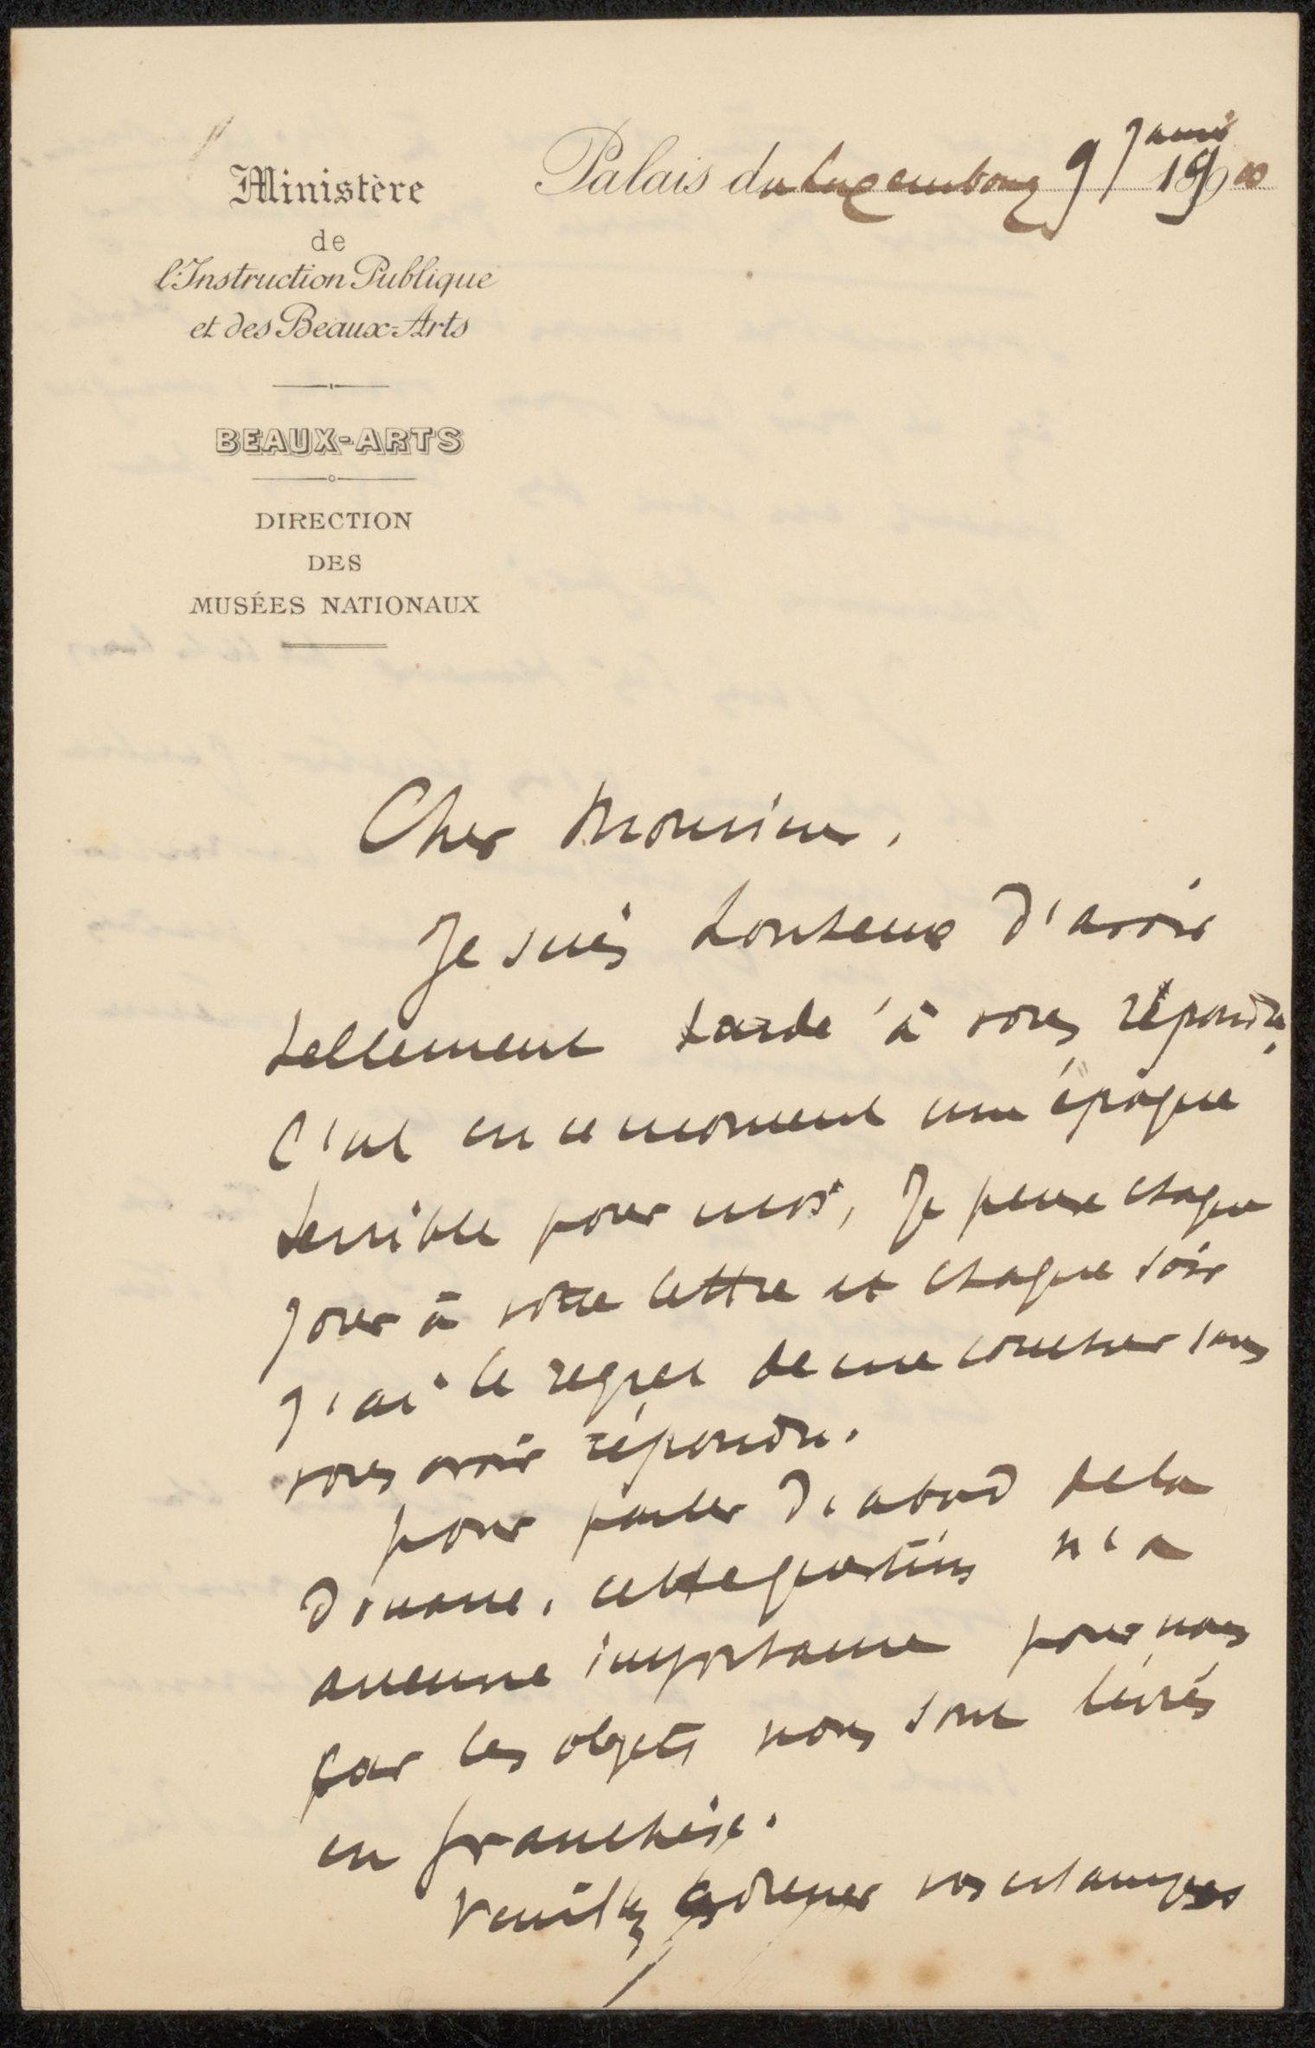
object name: letter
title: Brief aan Philip Zilcken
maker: léonce bénédite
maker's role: conservator, museumdirecteur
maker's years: 1856-1925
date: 1900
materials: ink, paper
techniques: pen, printing, writing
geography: palais du luxembourg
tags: nijmegen, print maker, adriaan pit, the hague, painter, draughtsman, philip zilcken, sending and receiving postal matter, the graphic arts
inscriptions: collector's mark: ‘RPK’